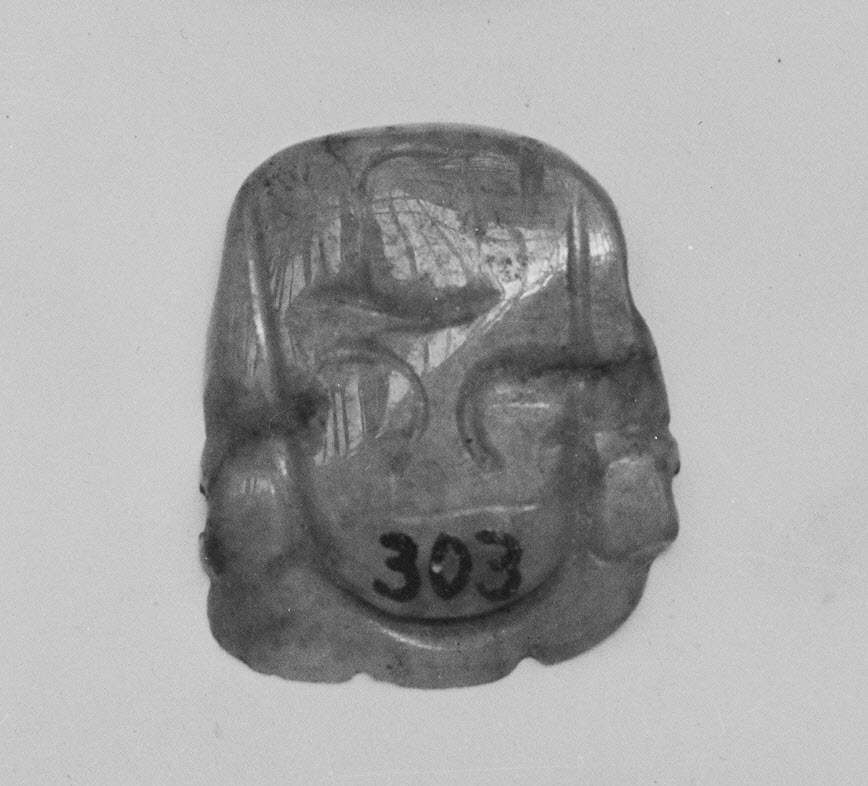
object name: mast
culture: guatemala or mexico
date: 1902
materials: jade